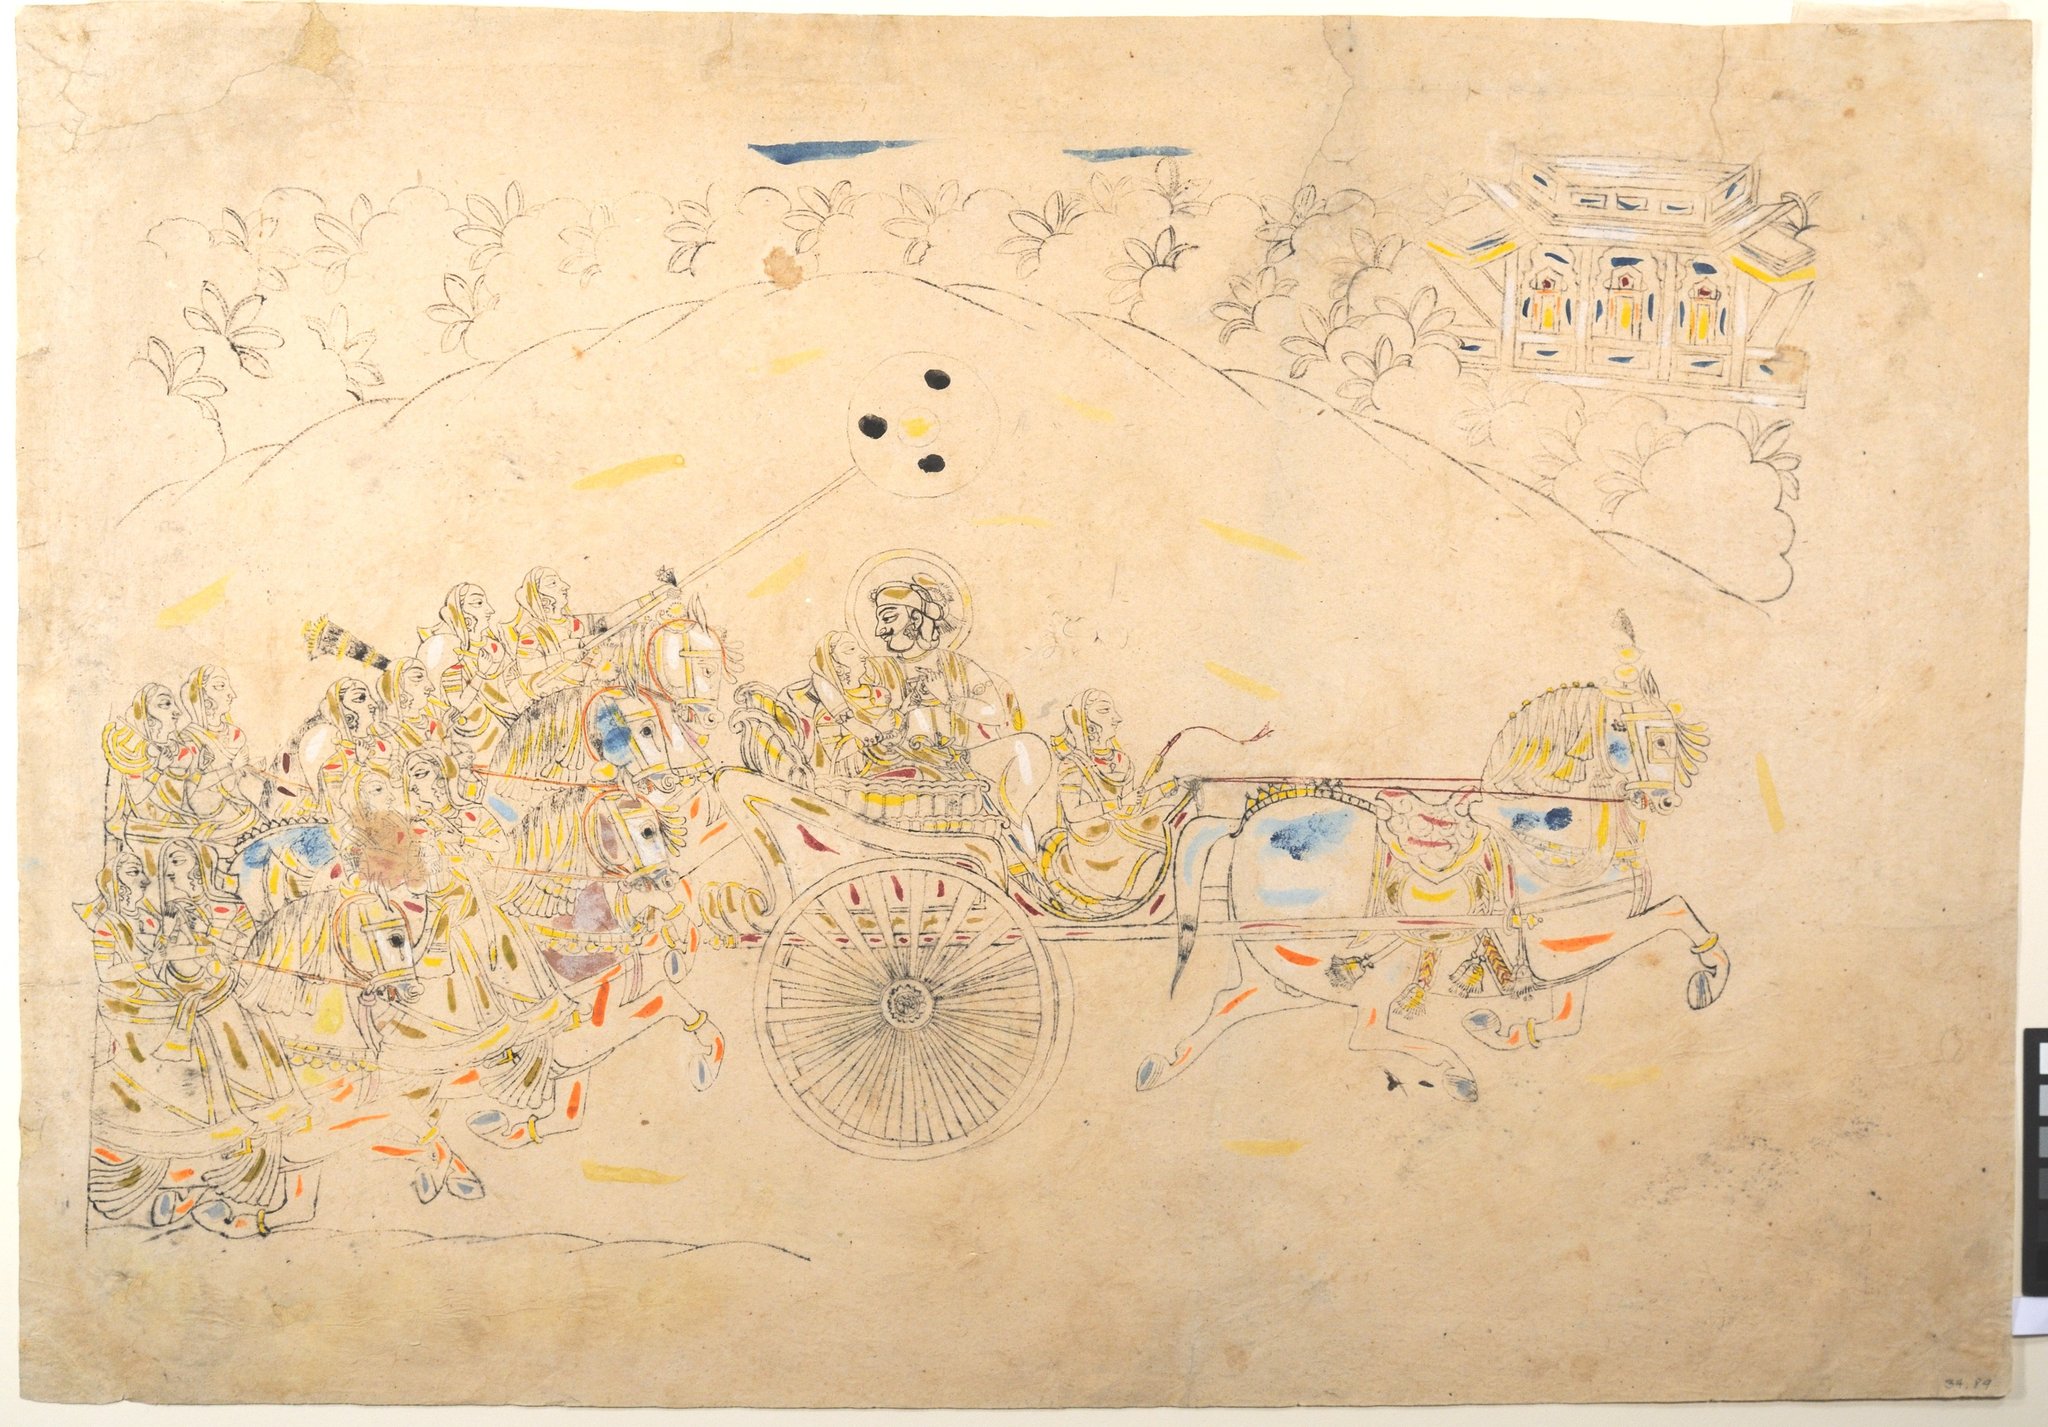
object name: painting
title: Preparatory Study for a Portrait of Man Singh and His Harem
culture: indian, rajasthan, jodhpur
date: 1810-1815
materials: ink, paper, watercolor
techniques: transfer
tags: men,women,horses,carriages